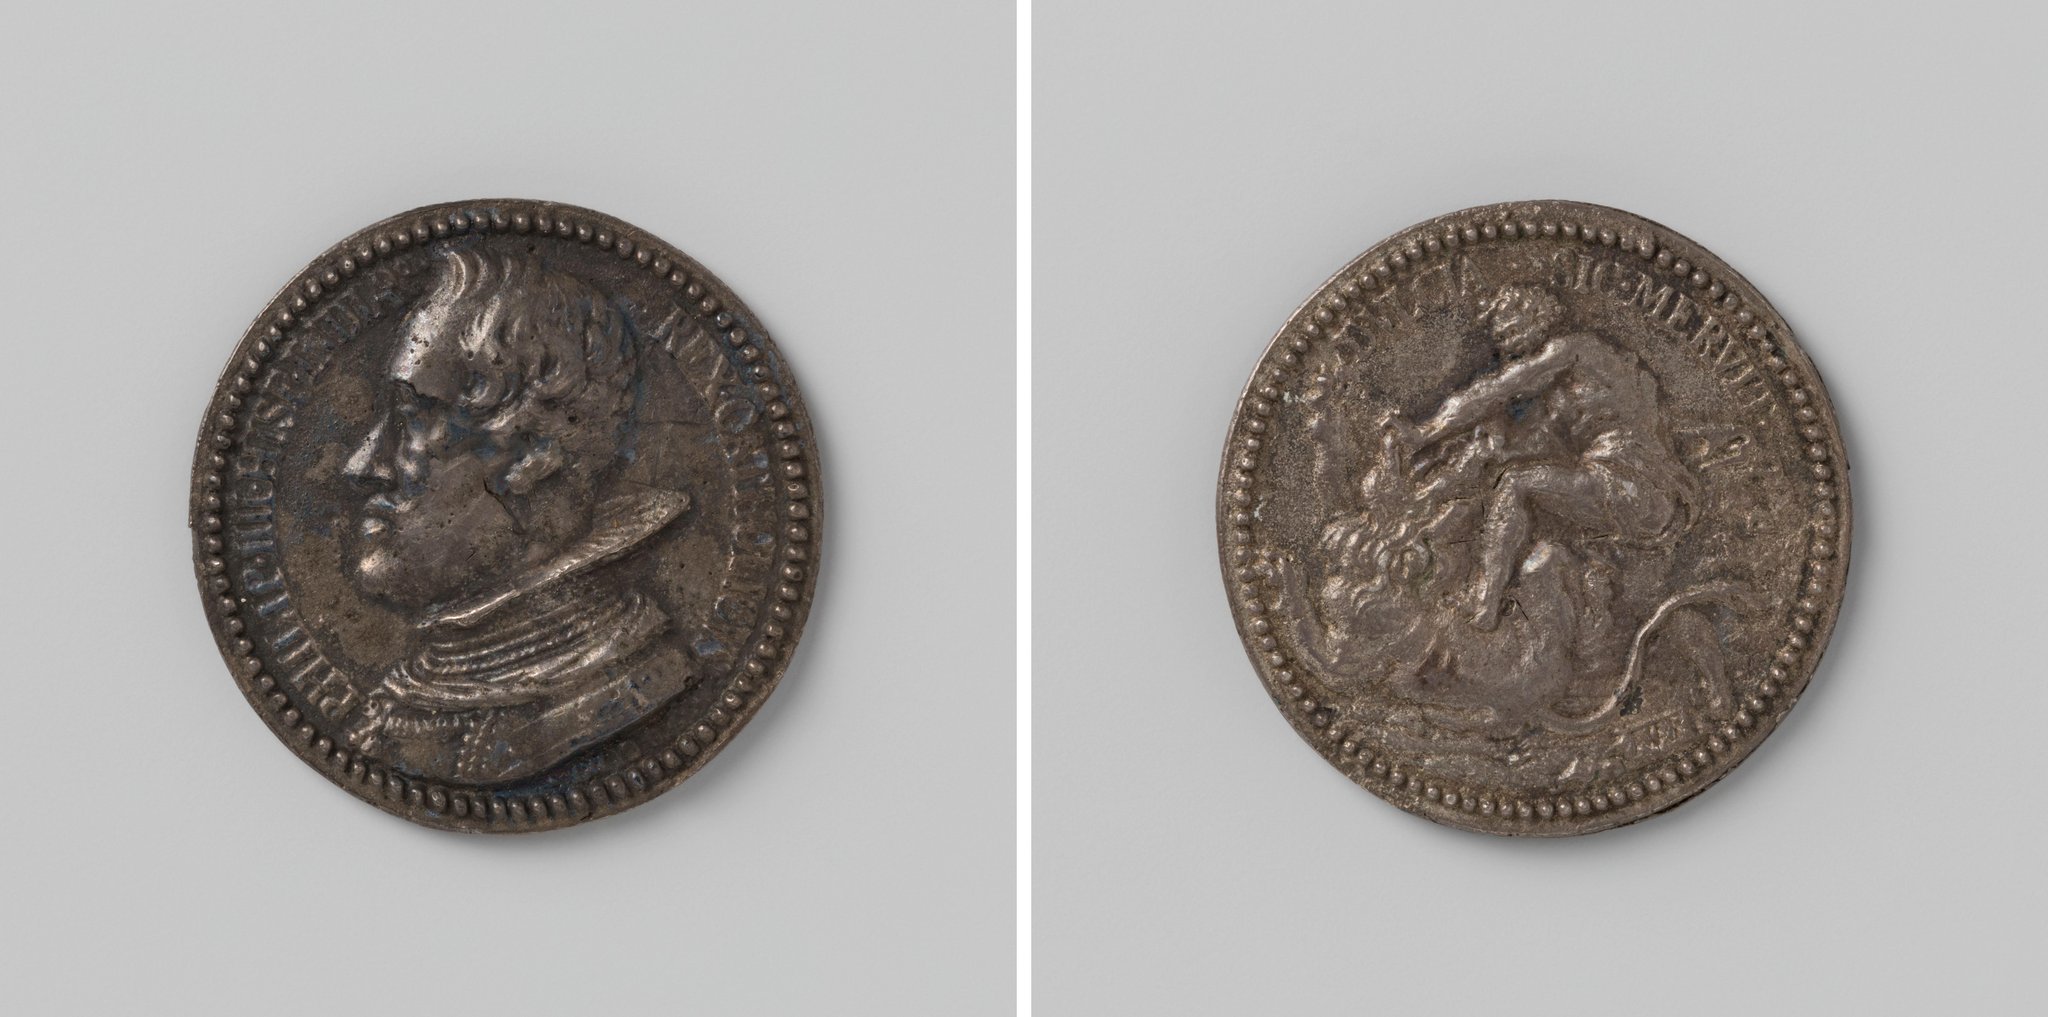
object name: history medal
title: Overwinning op de Nederlandse vloot onder admiraal de Pater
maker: adriaan waterloos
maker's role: medailleur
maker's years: 1600-1684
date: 1631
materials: silver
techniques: casting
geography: brussels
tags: filips iv (koning van spanje)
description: Zilveren penning. Voorzijde: borststuk man (Philips IV) binnen omschrift. Keerzijde: Simson vechtend met leeuw binnen omschrift